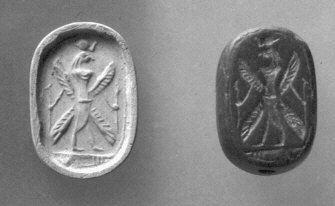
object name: stamp seal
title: Scaraboid seal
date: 600-501 BCE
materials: stone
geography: levant or syria